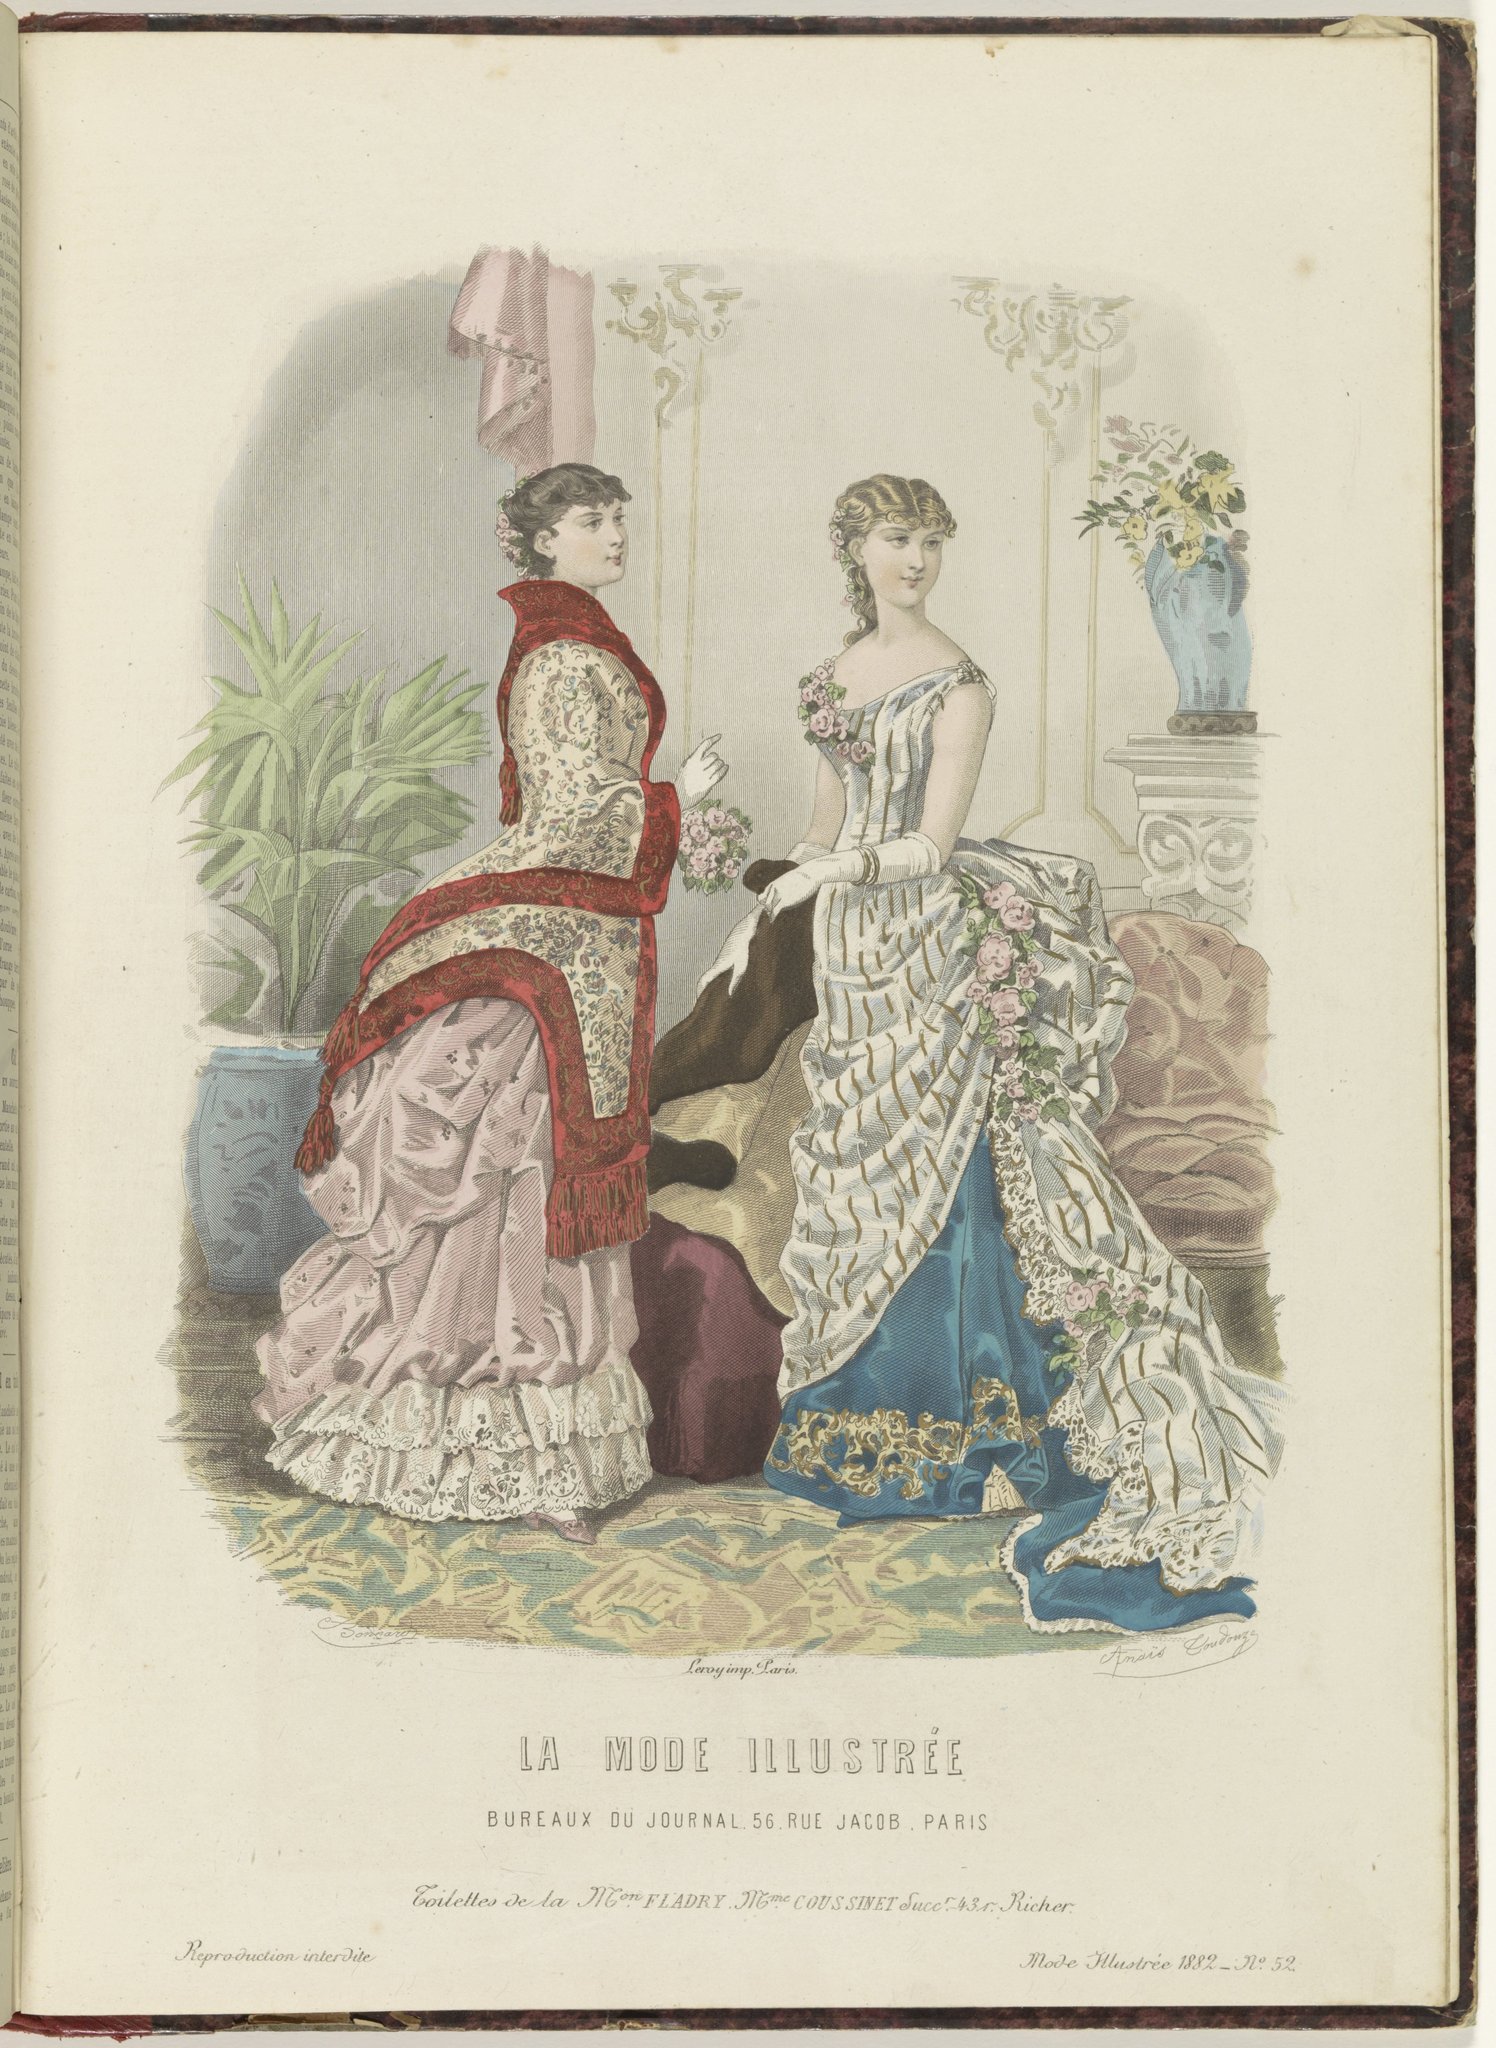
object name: magazine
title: La Mode Illustrée, Journal de la Famille, 1882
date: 1882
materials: paper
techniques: engraving, hand coloring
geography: paris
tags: fashion plates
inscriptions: date